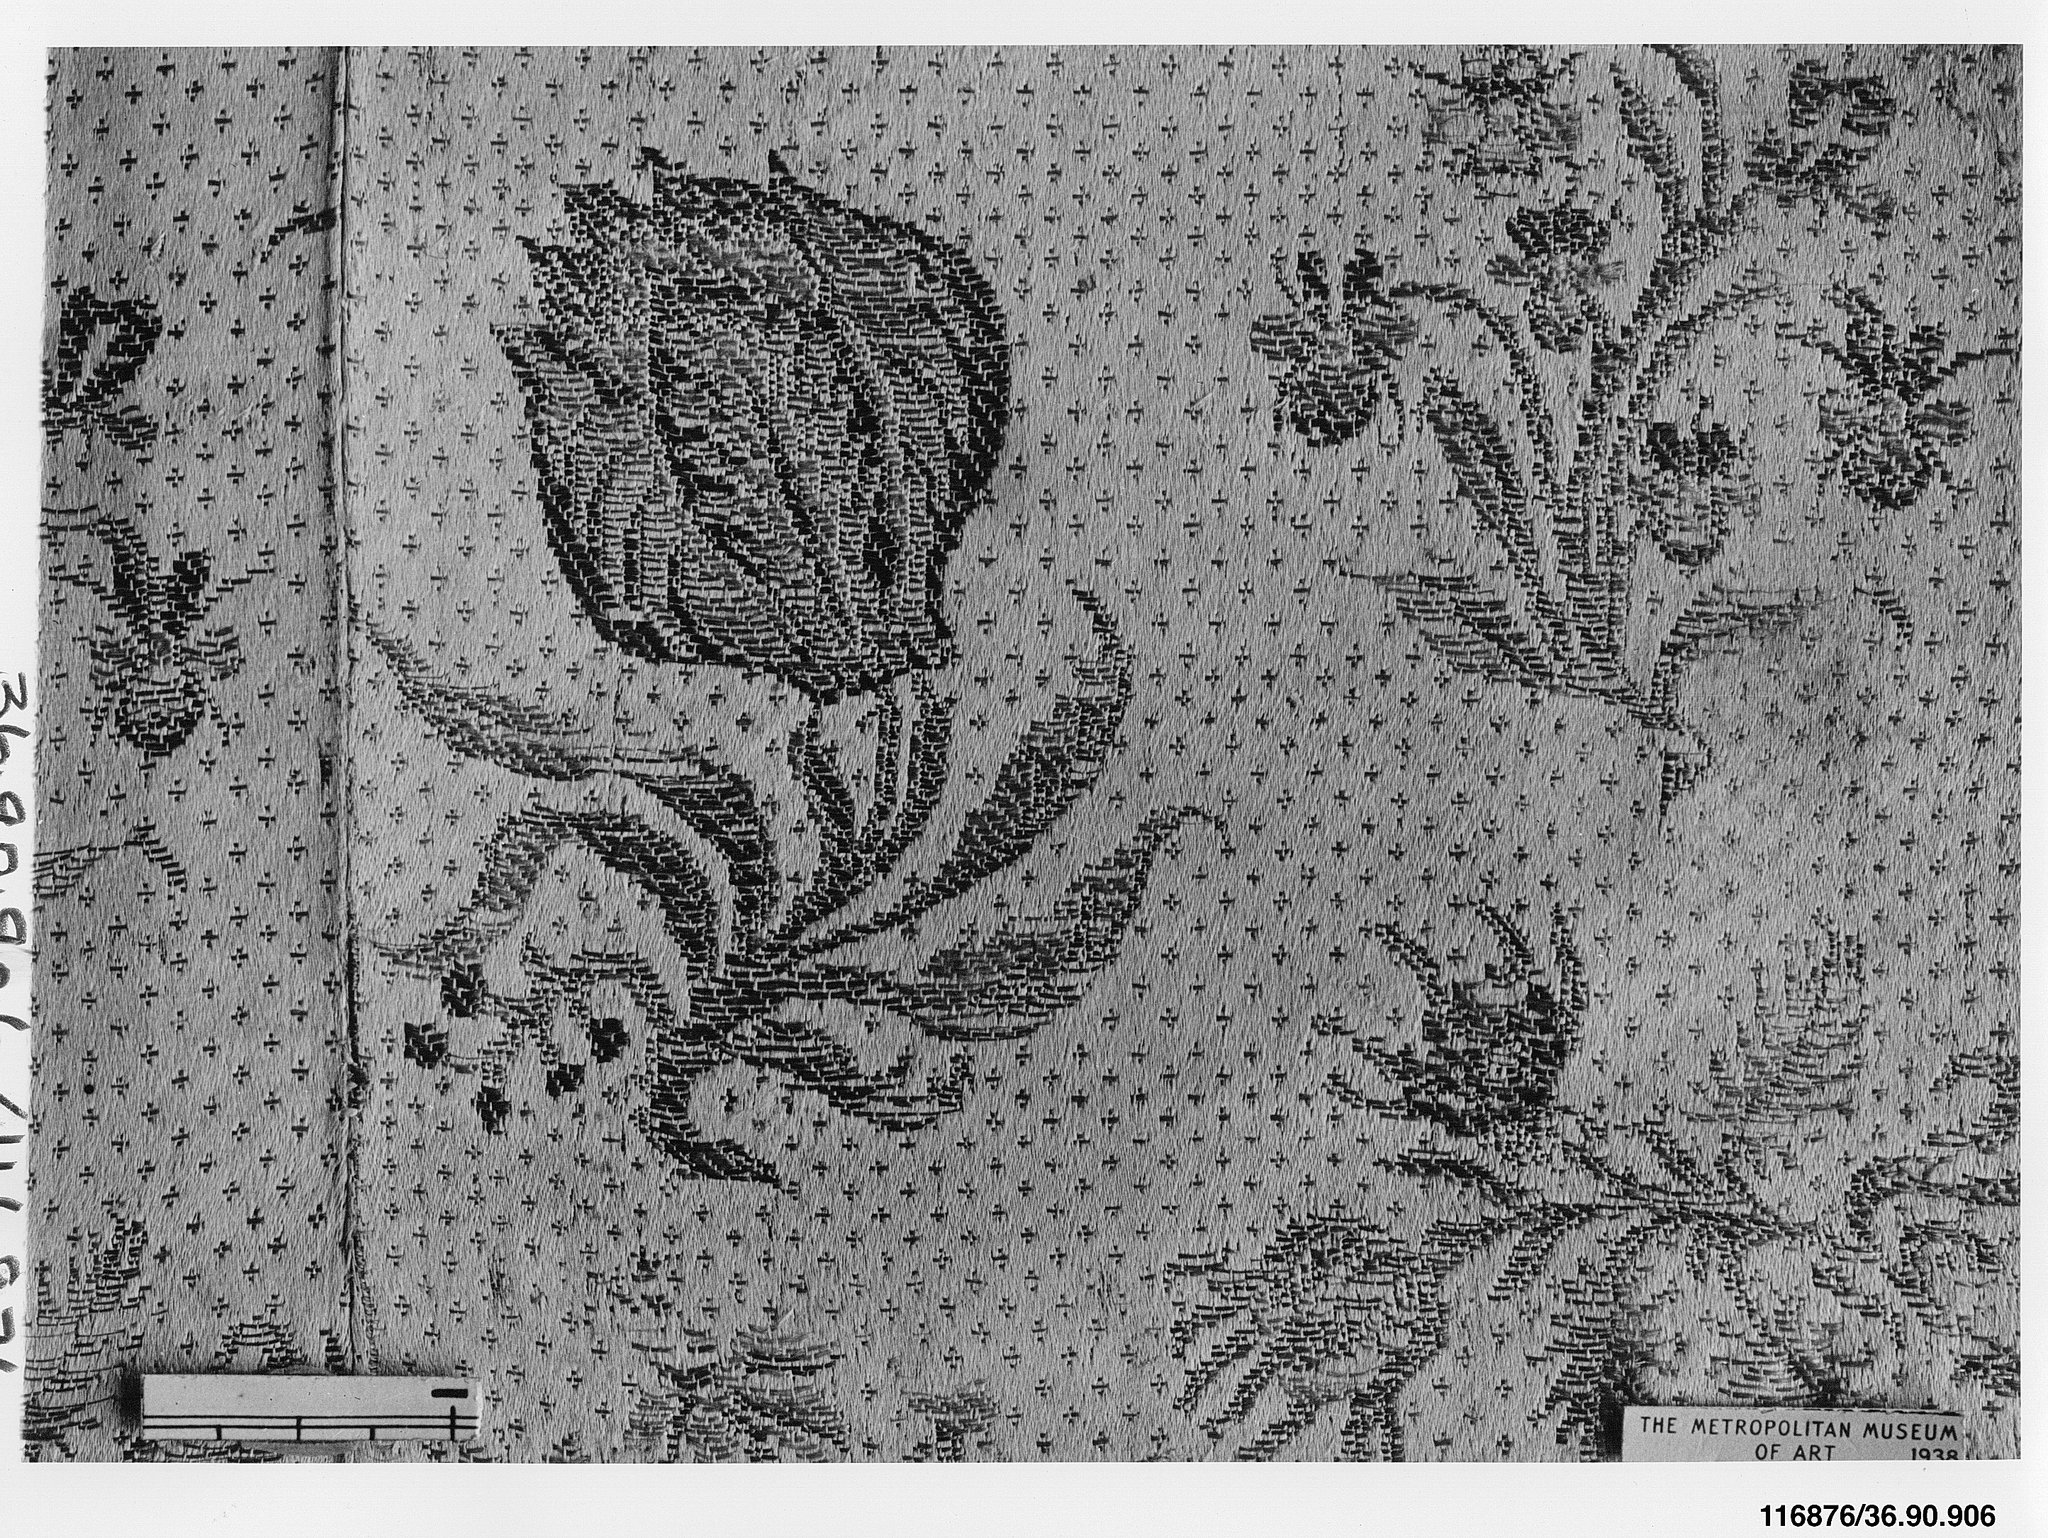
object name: piece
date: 1680-1700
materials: silk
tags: flowers,leaves